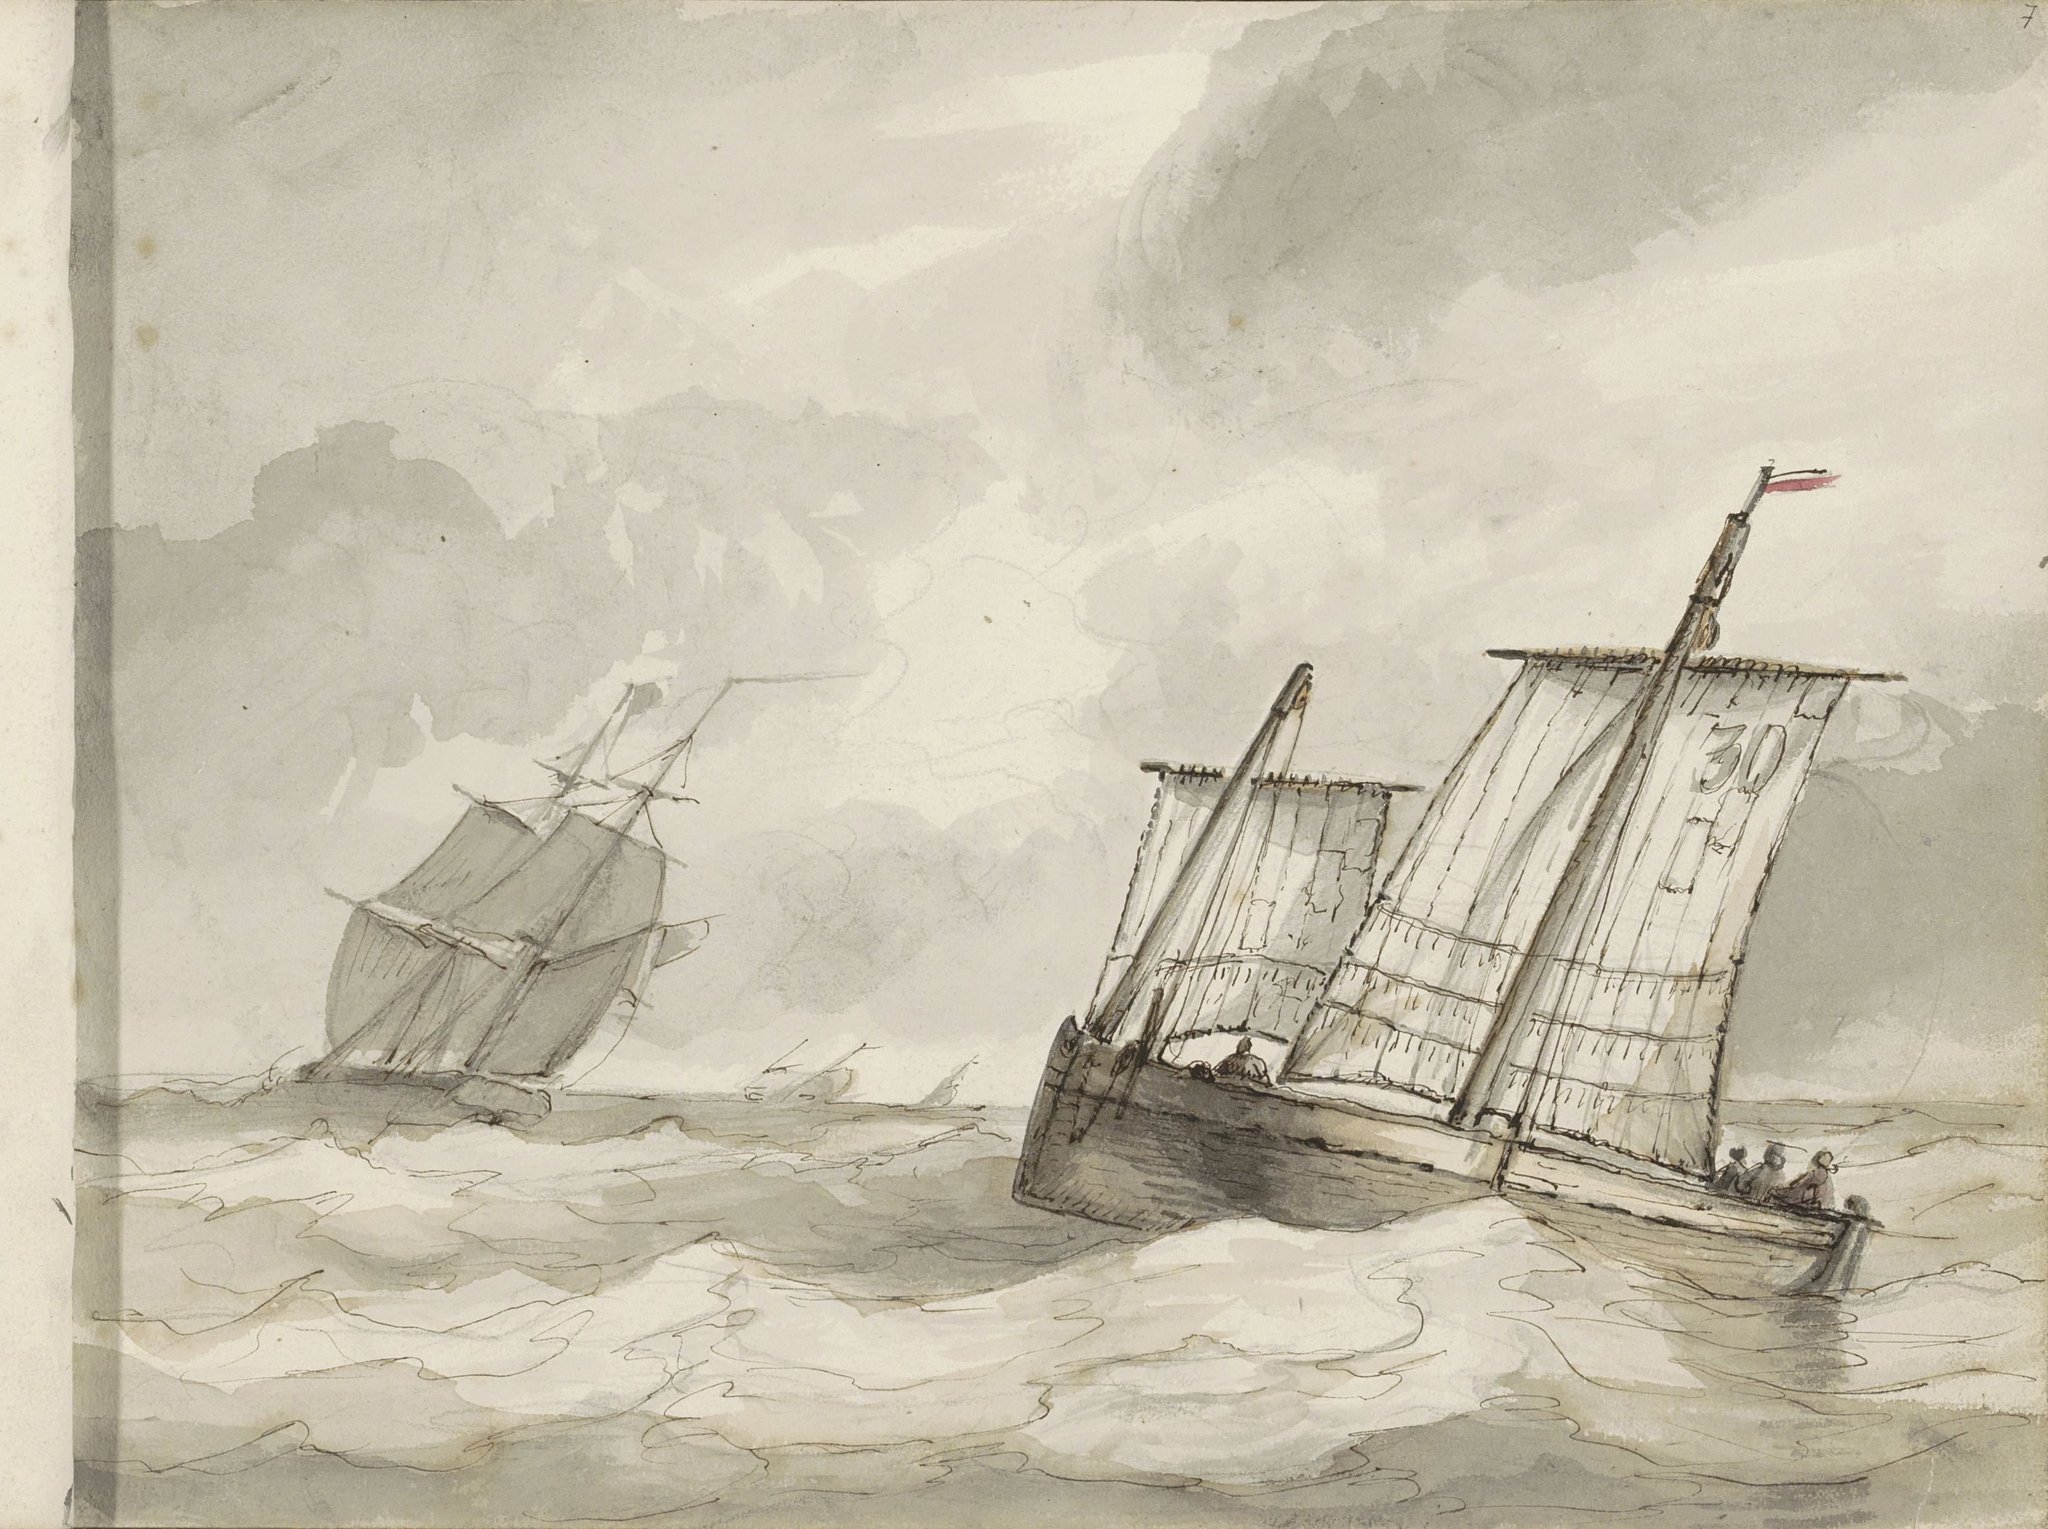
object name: sketchbook leaf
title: Zeilschepen op een woelige zee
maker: petrus johannes schotel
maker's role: draughtsman, painter, print maker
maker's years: 1808-1865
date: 1825-1875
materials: ink, paper, pencil, watercolor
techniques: brush, pen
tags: sea (seascape)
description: Blad 7 recto uit een schetsboek met 44 bladen.